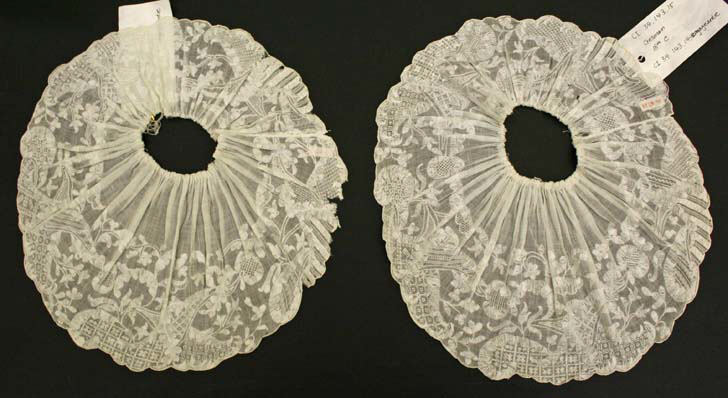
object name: engageantes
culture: european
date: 1701-1800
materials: cotton